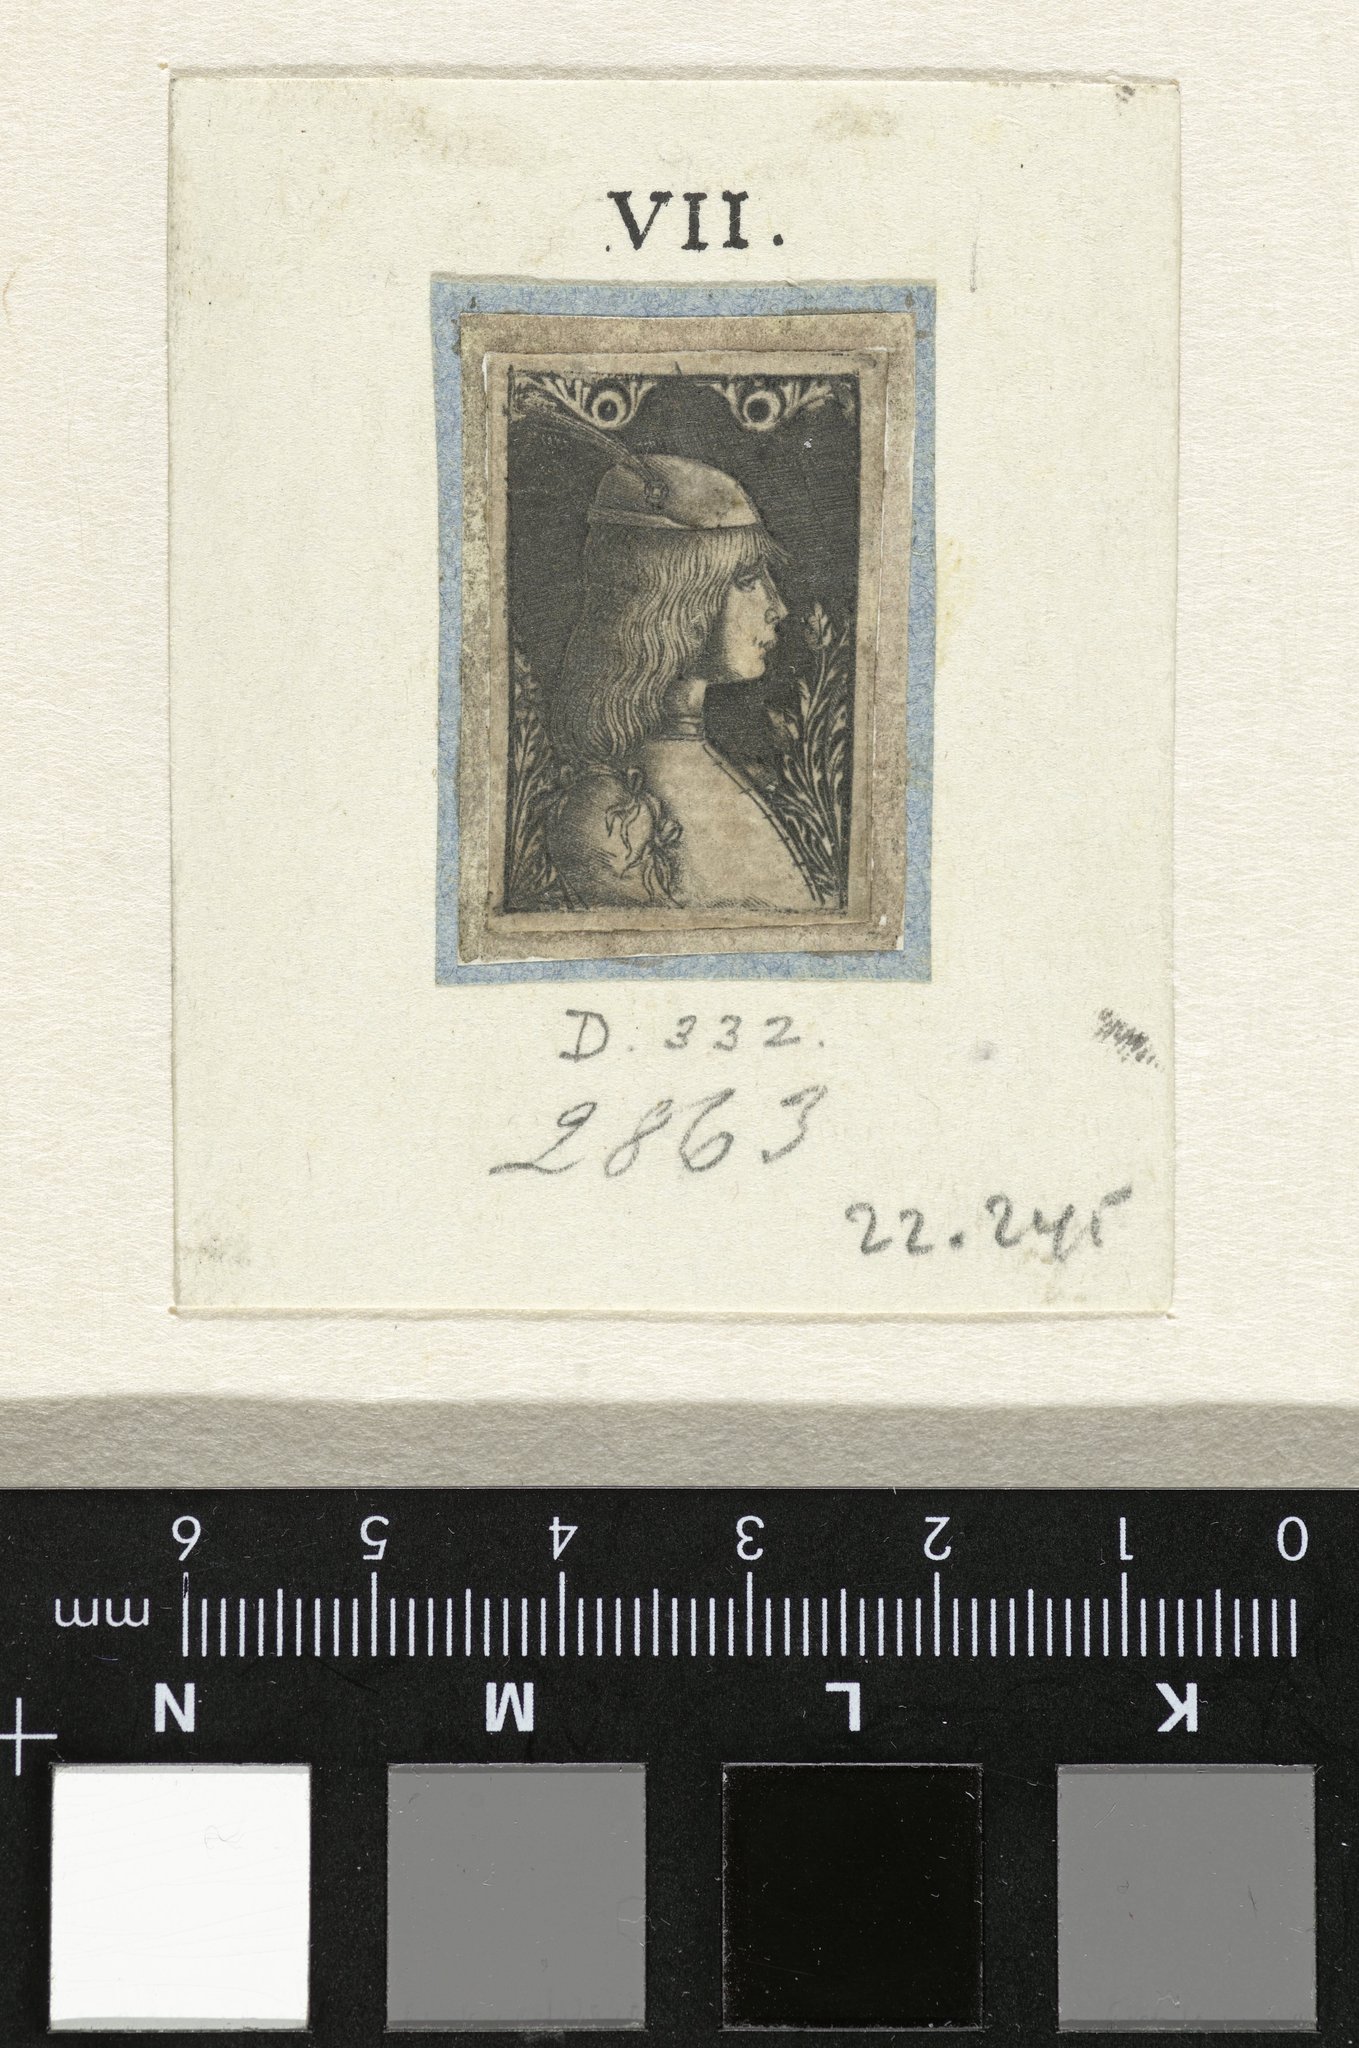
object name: print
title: Portret van een jongeman met muts met veer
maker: Anonymous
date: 1480-1520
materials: niello, paper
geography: bologna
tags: male sex; man